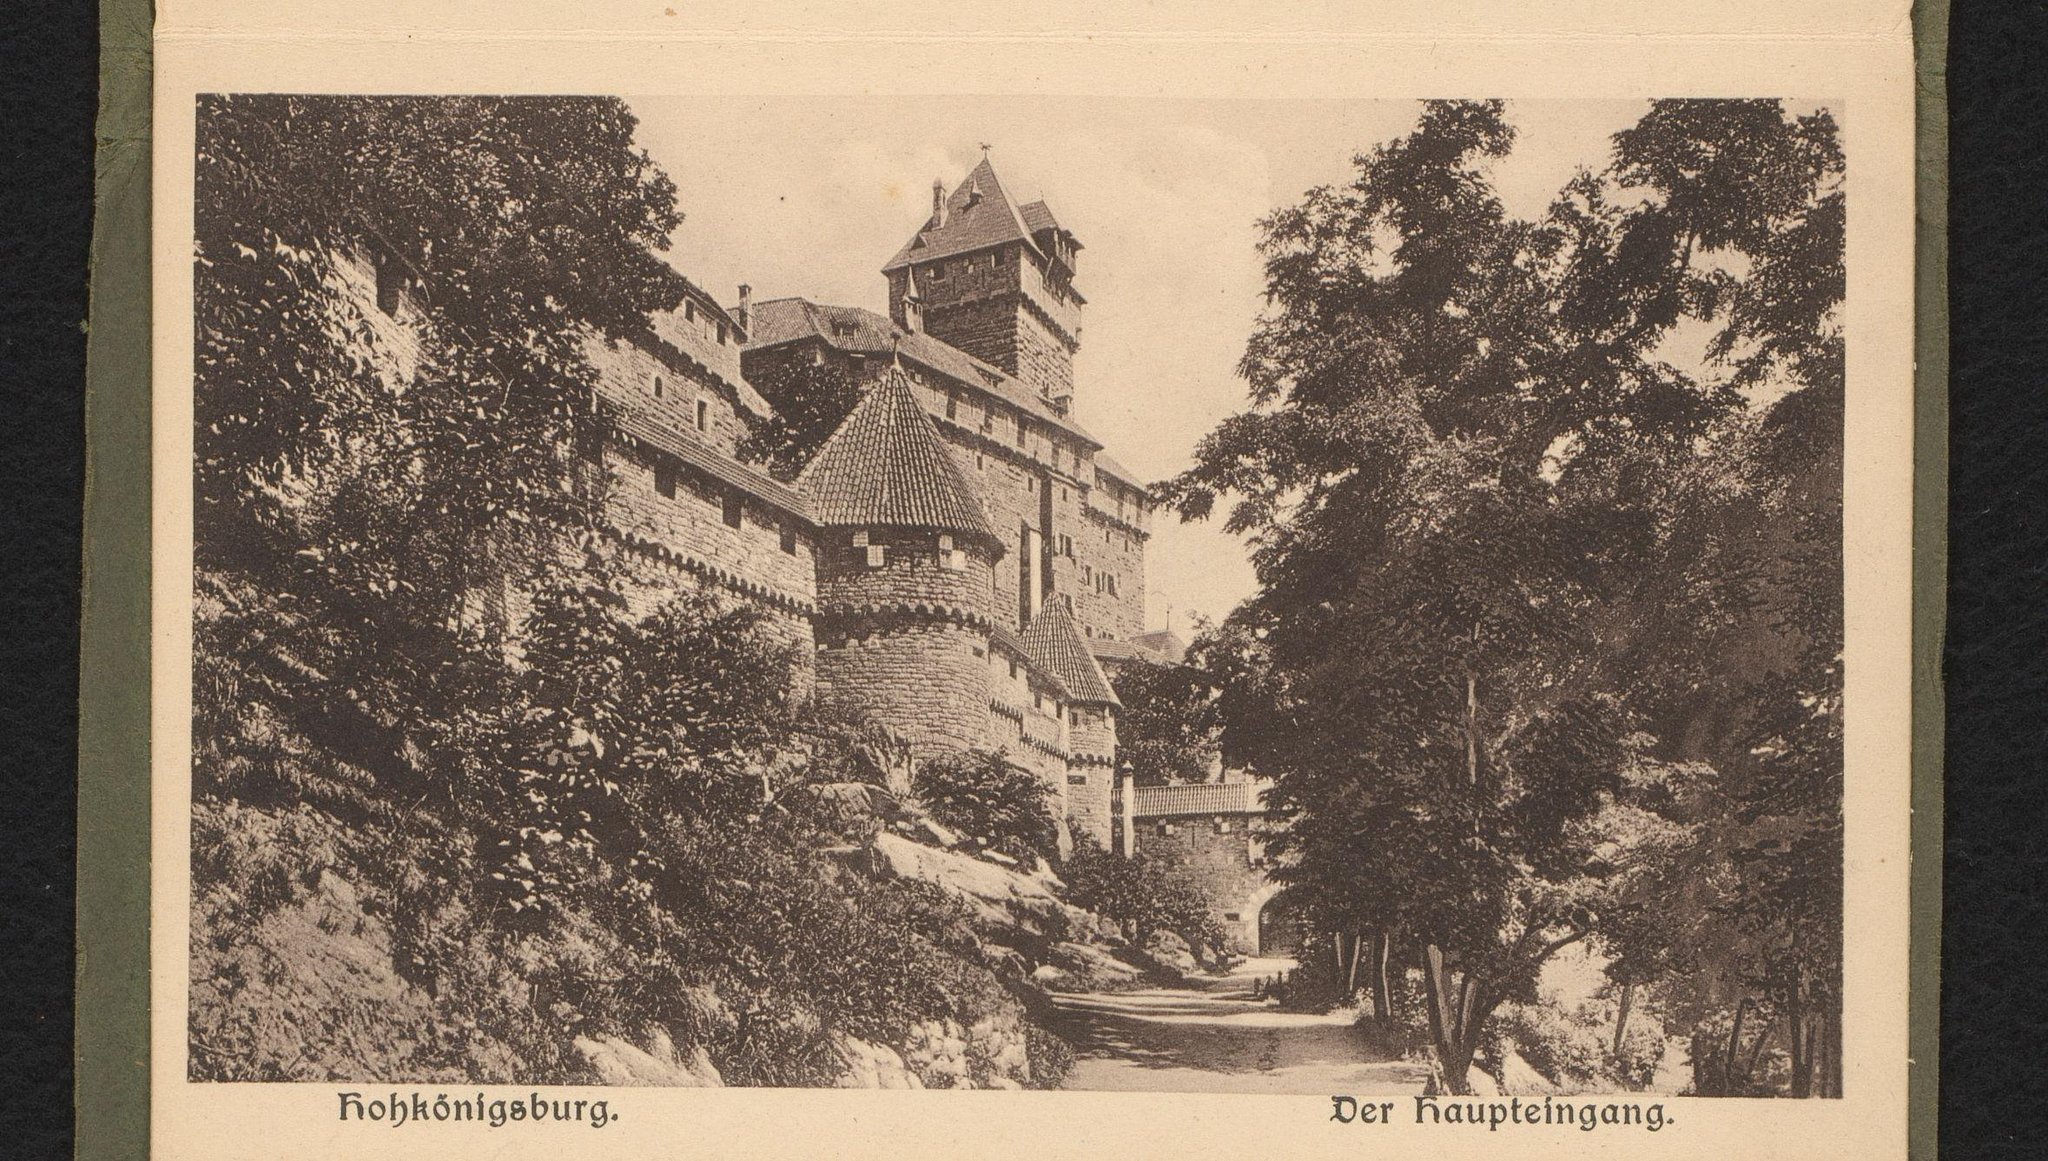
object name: photomechanical print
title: Hohkönigsburg. Der Haupteingang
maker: Anonymous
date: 1908-1913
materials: cardboard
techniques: photograph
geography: alsace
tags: castle, gate, entrance